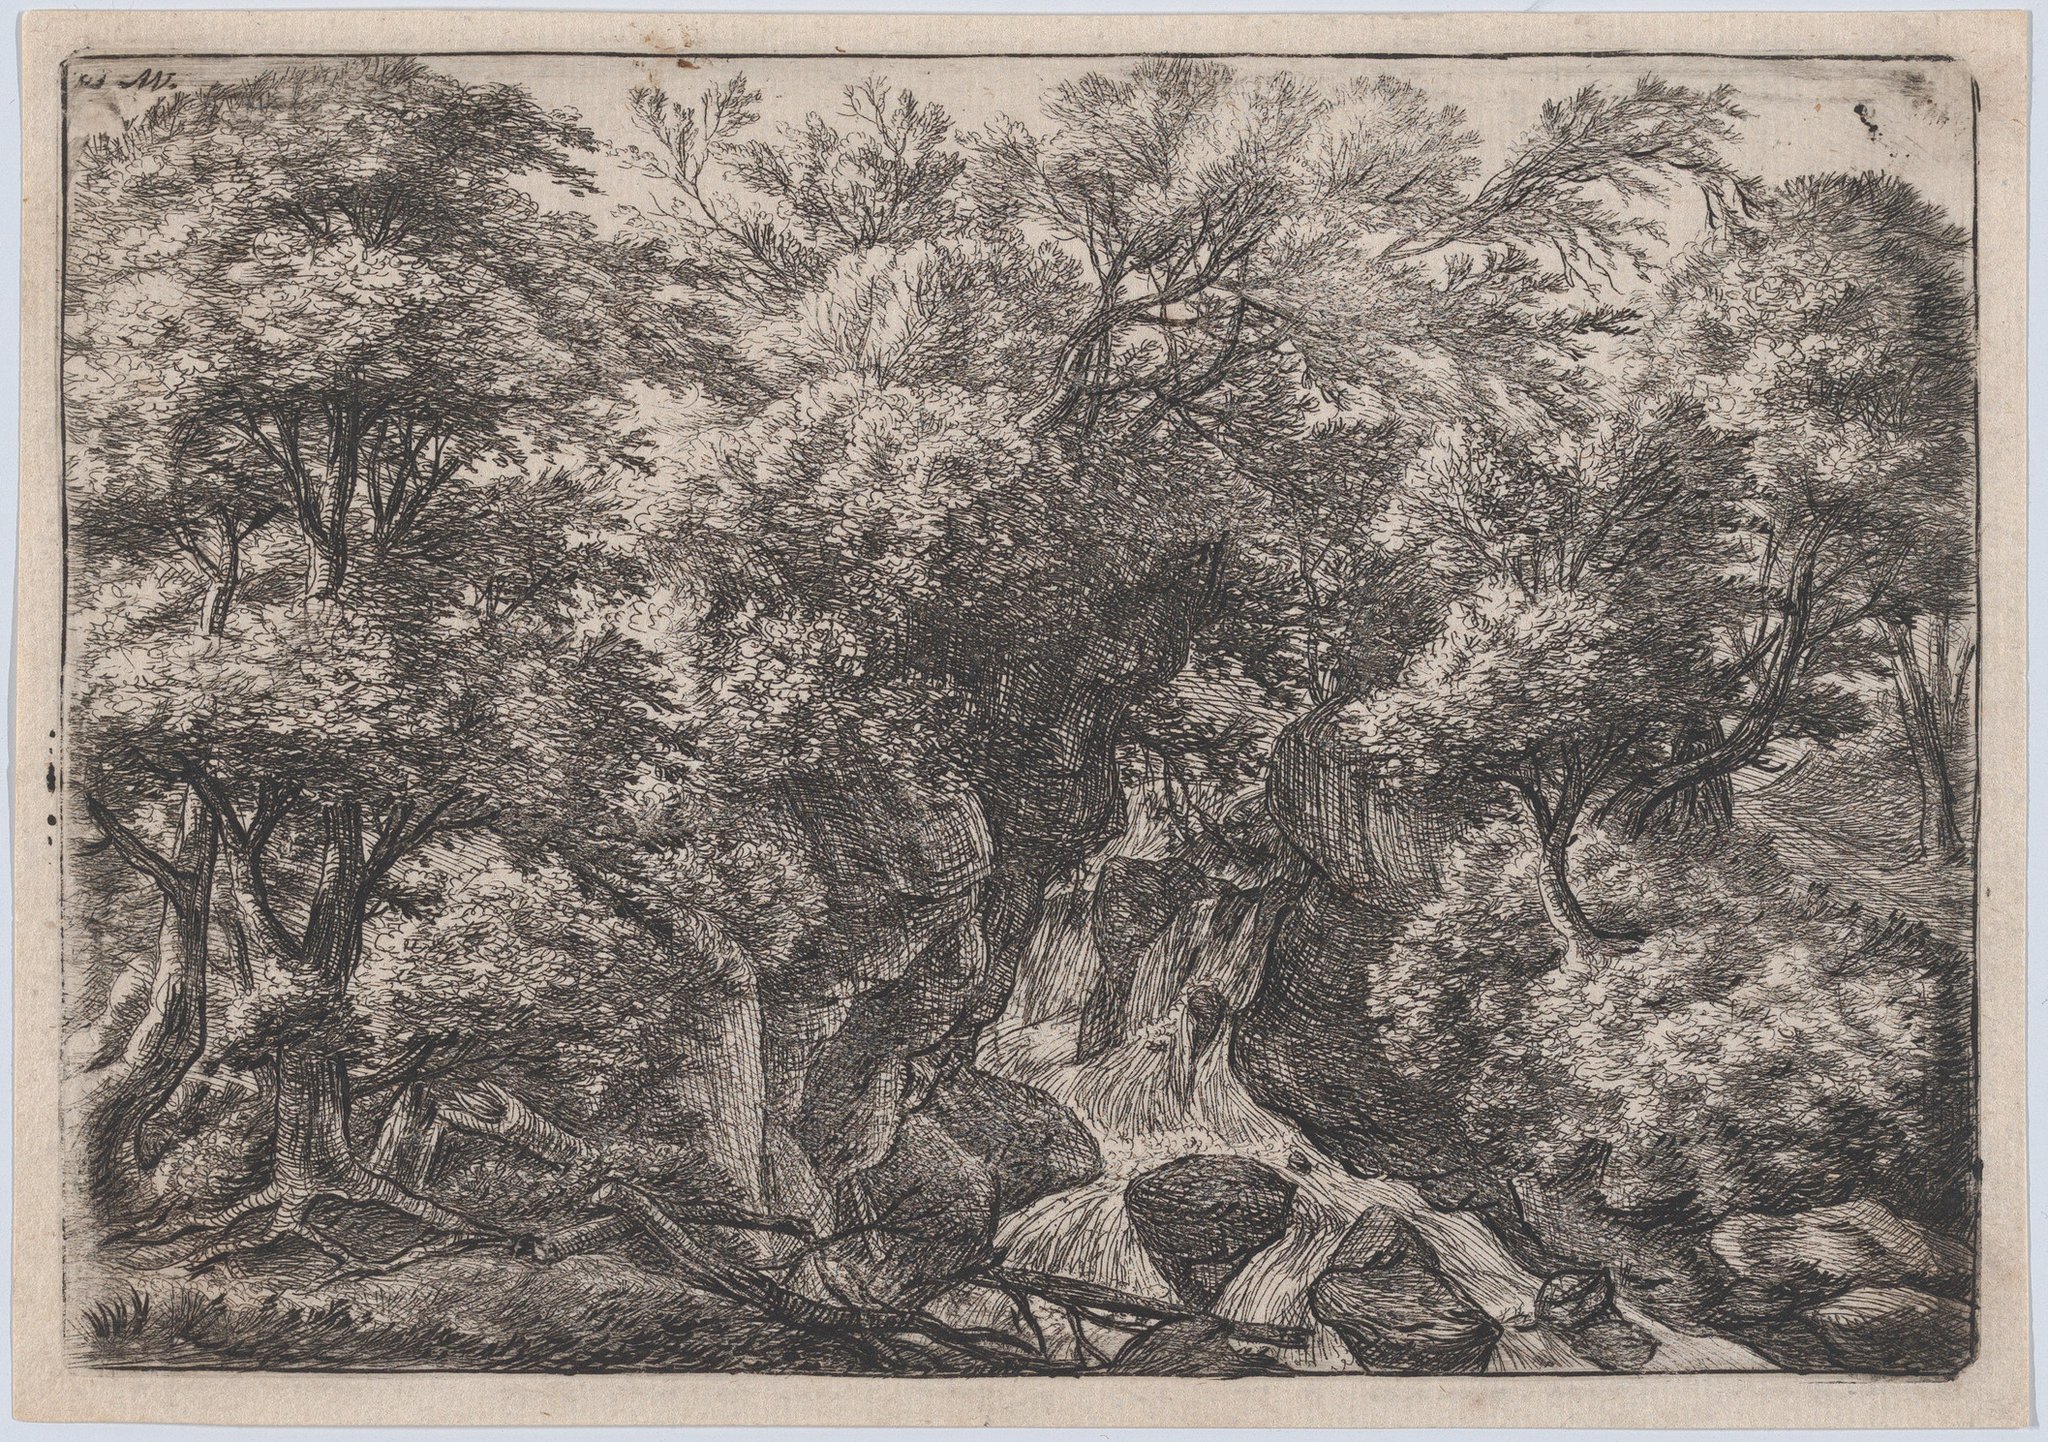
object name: print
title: The Large Waterfall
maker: anthonie waterloo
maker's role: artist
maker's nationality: dutch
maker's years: 1609-1690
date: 1601-1700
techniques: etching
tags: waterfalls,trees